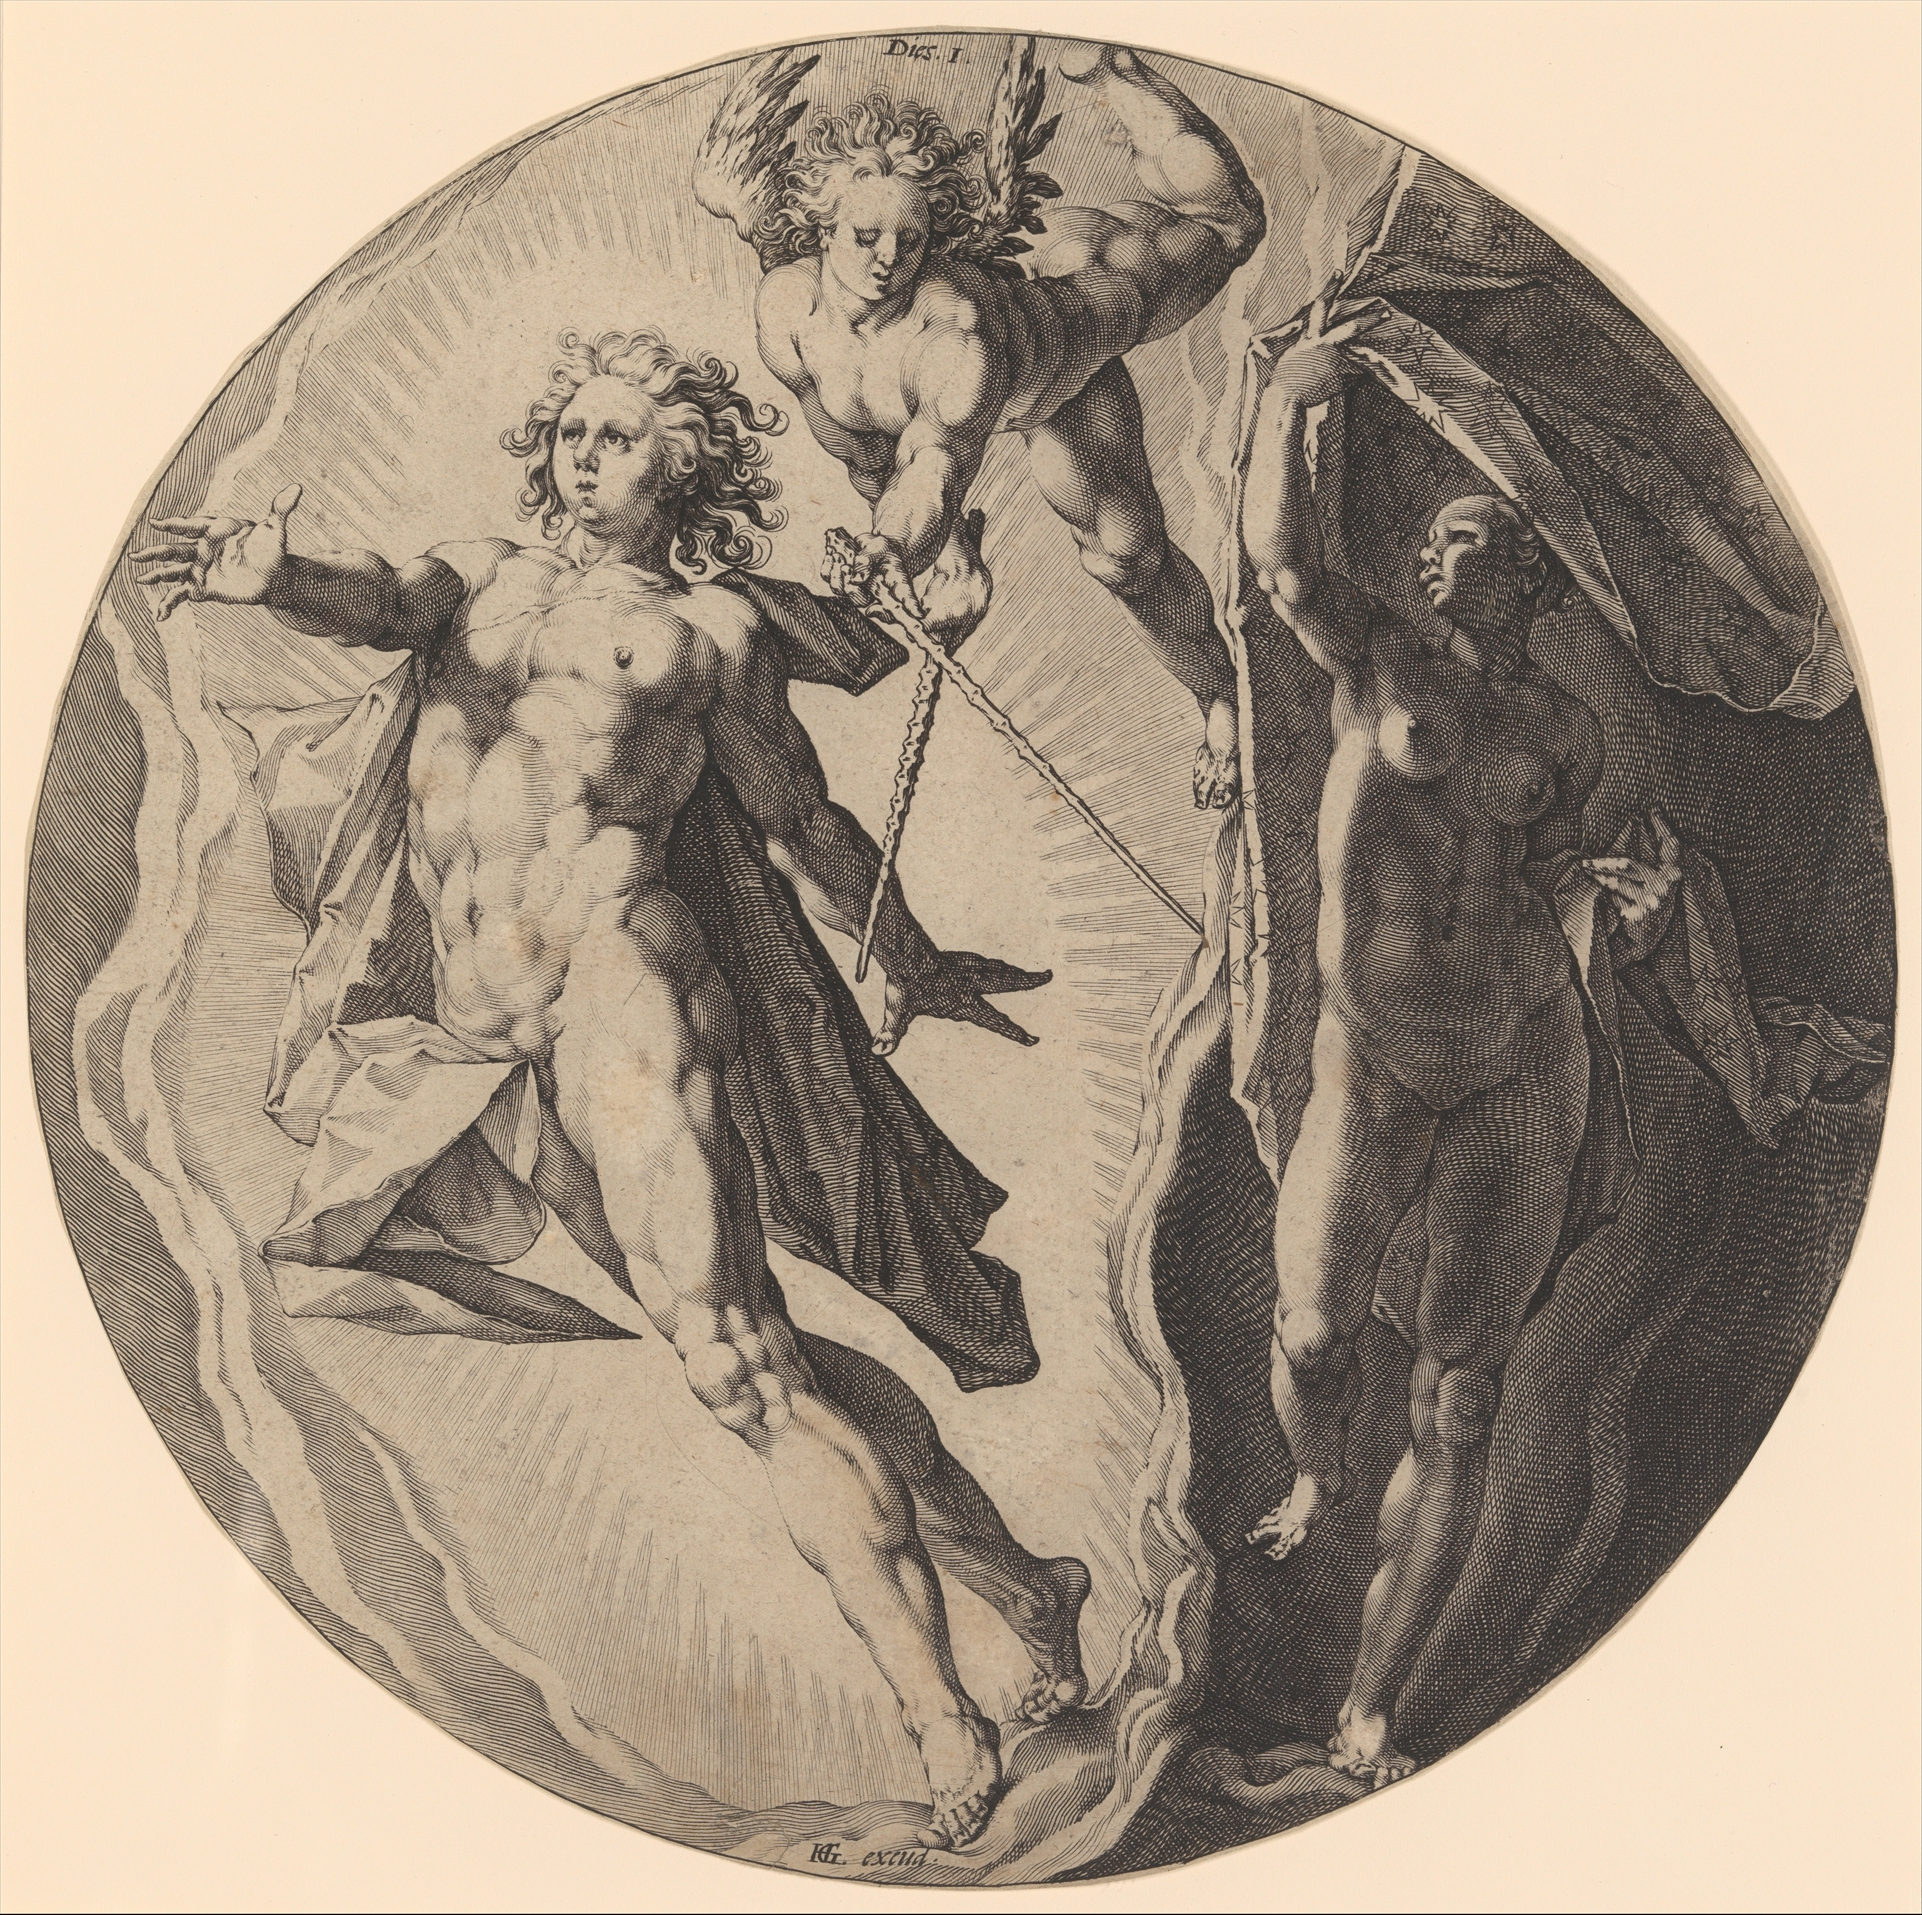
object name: print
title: The First Day (Dies I): The Separation of Darkness and Light, plate 1 from "The Creation of the World"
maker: jan muller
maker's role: artist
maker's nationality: netherlandish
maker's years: 1571-1628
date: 1589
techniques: engraving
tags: male nudes,female nudes